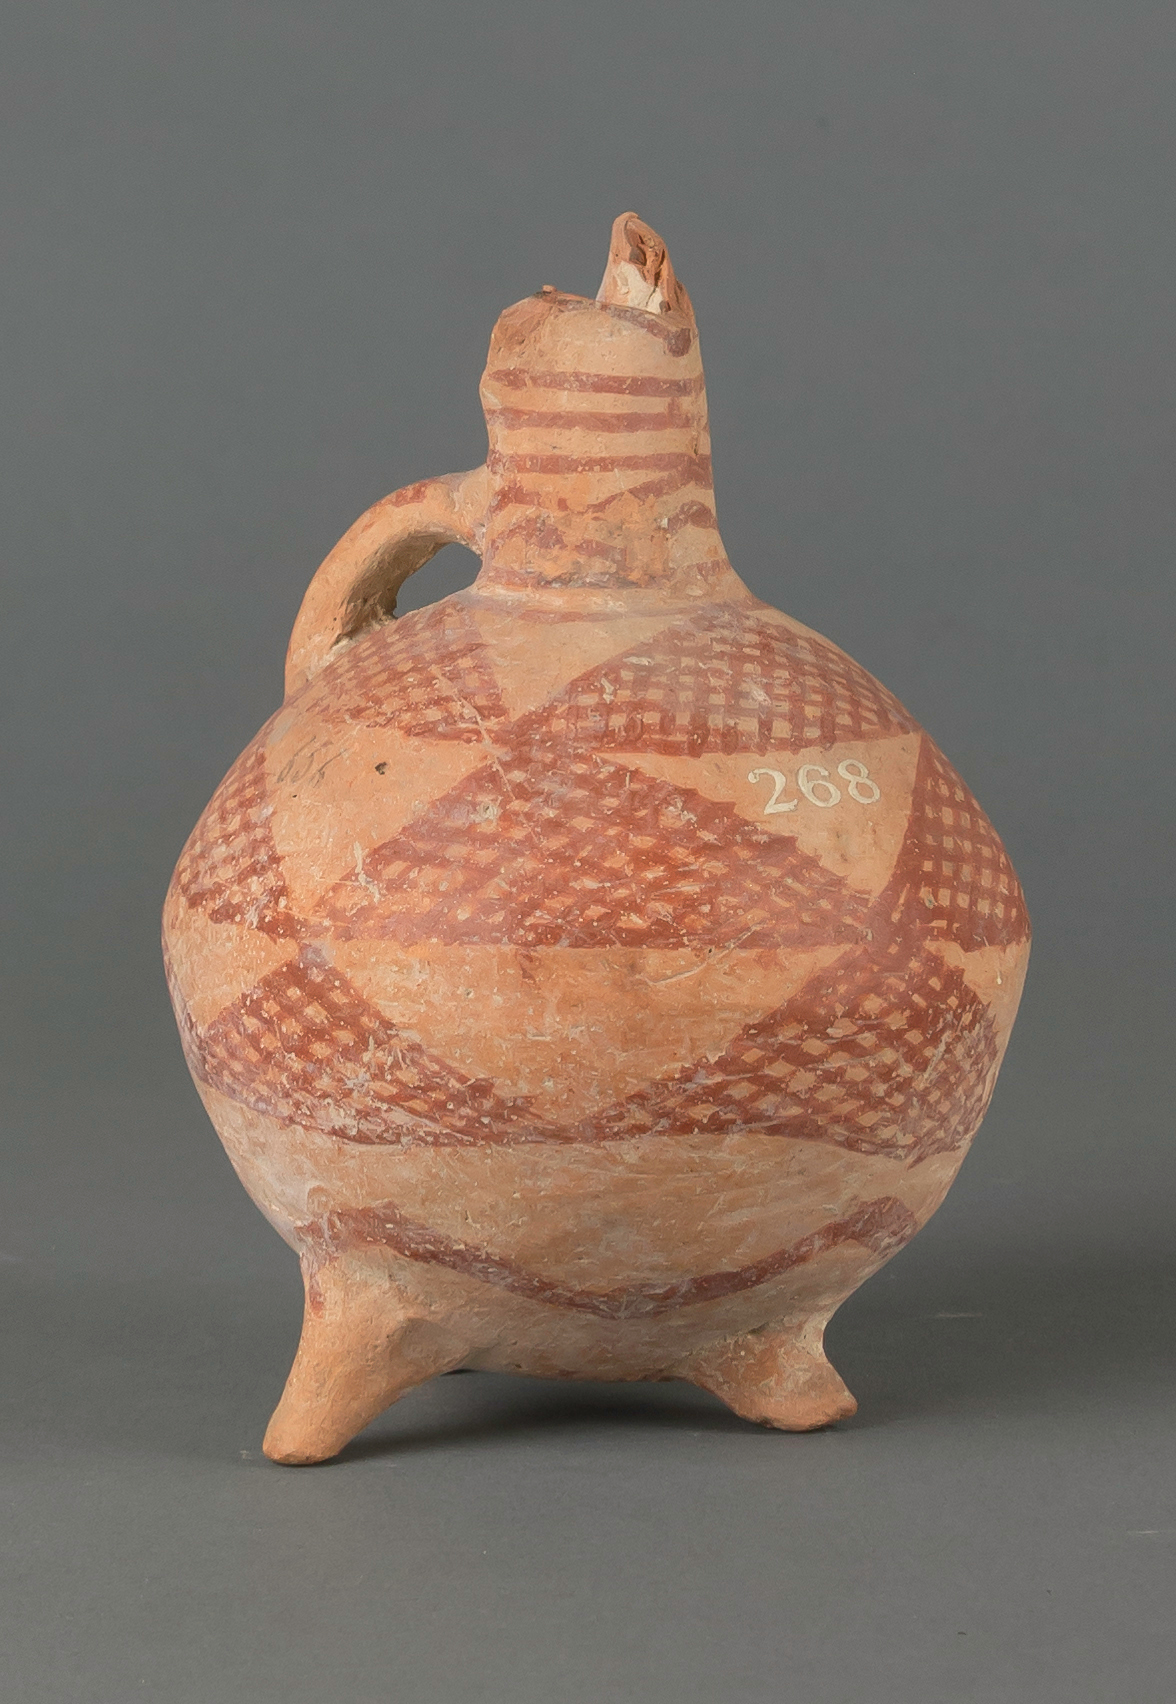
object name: jug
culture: cypriot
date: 2000-1600 BCE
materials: terracotta